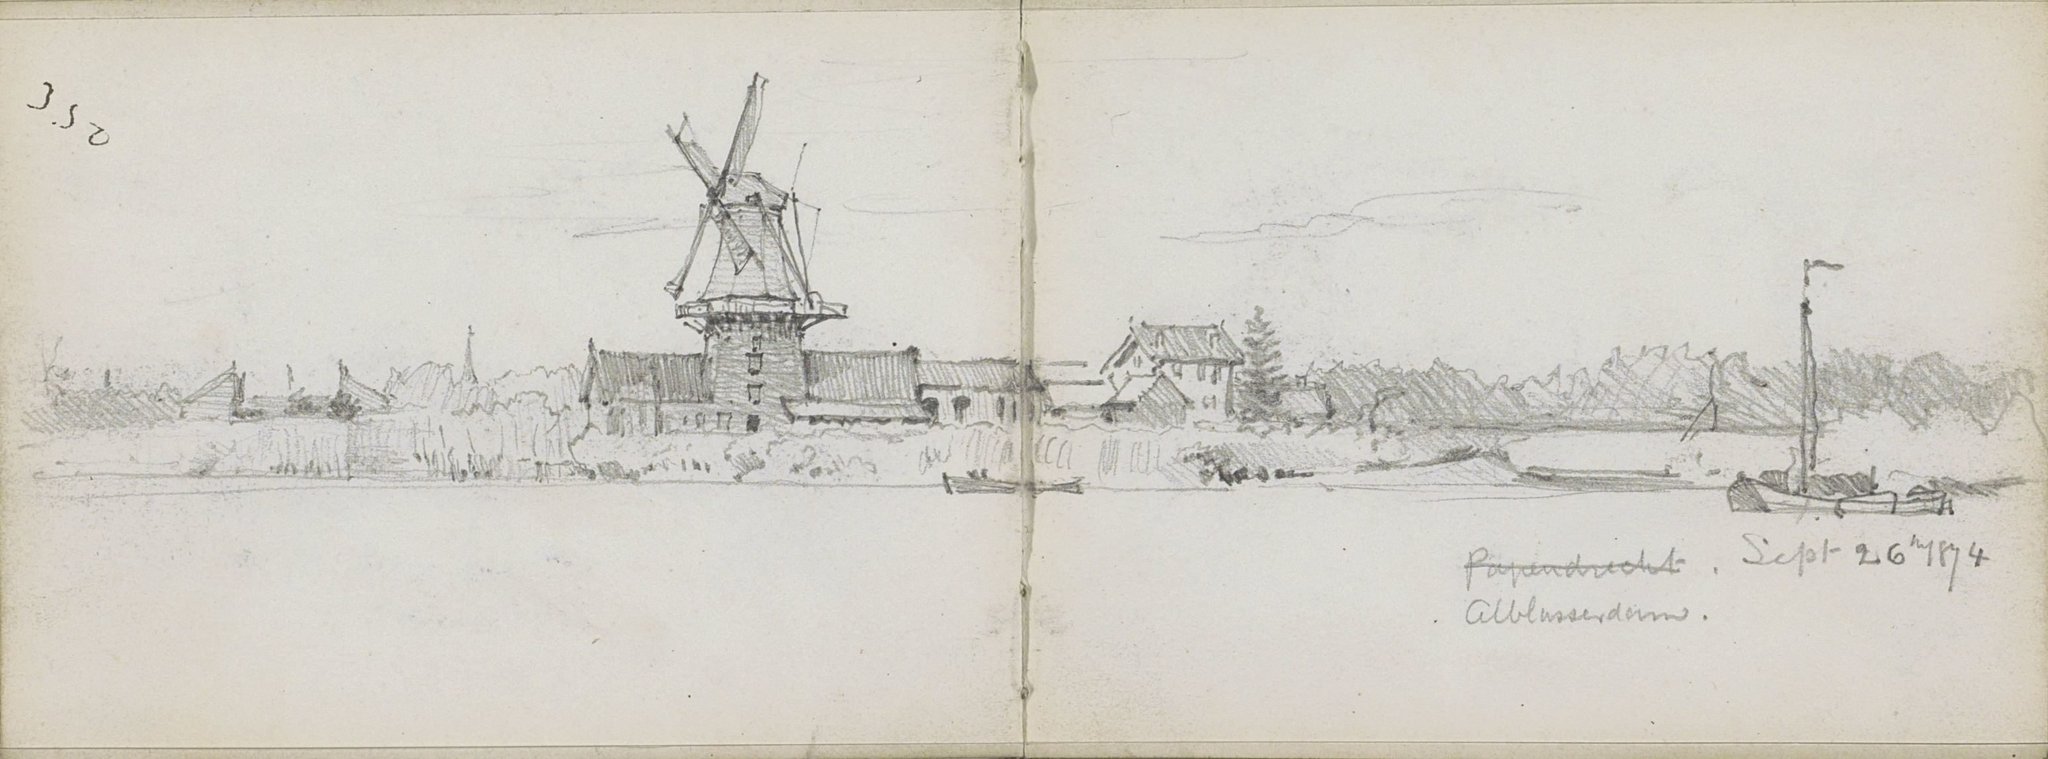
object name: sketchbook leaf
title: Gezicht op Alblasserdam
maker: george clausen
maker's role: draughtsman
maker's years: 1852-1912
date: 1809-1874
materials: paper, pencil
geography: alblasserdam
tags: city-view, and landscape with man-made constructions, landscapes, windmill in landscape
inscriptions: date and inscription: ‘Alblasserdam./ Sept 26 [...] 1874’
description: Op de voorgrond zeil- en roeiboten en een molen. Blad 9 verso en 10 recto uit een schetsboek met 37 bladen.